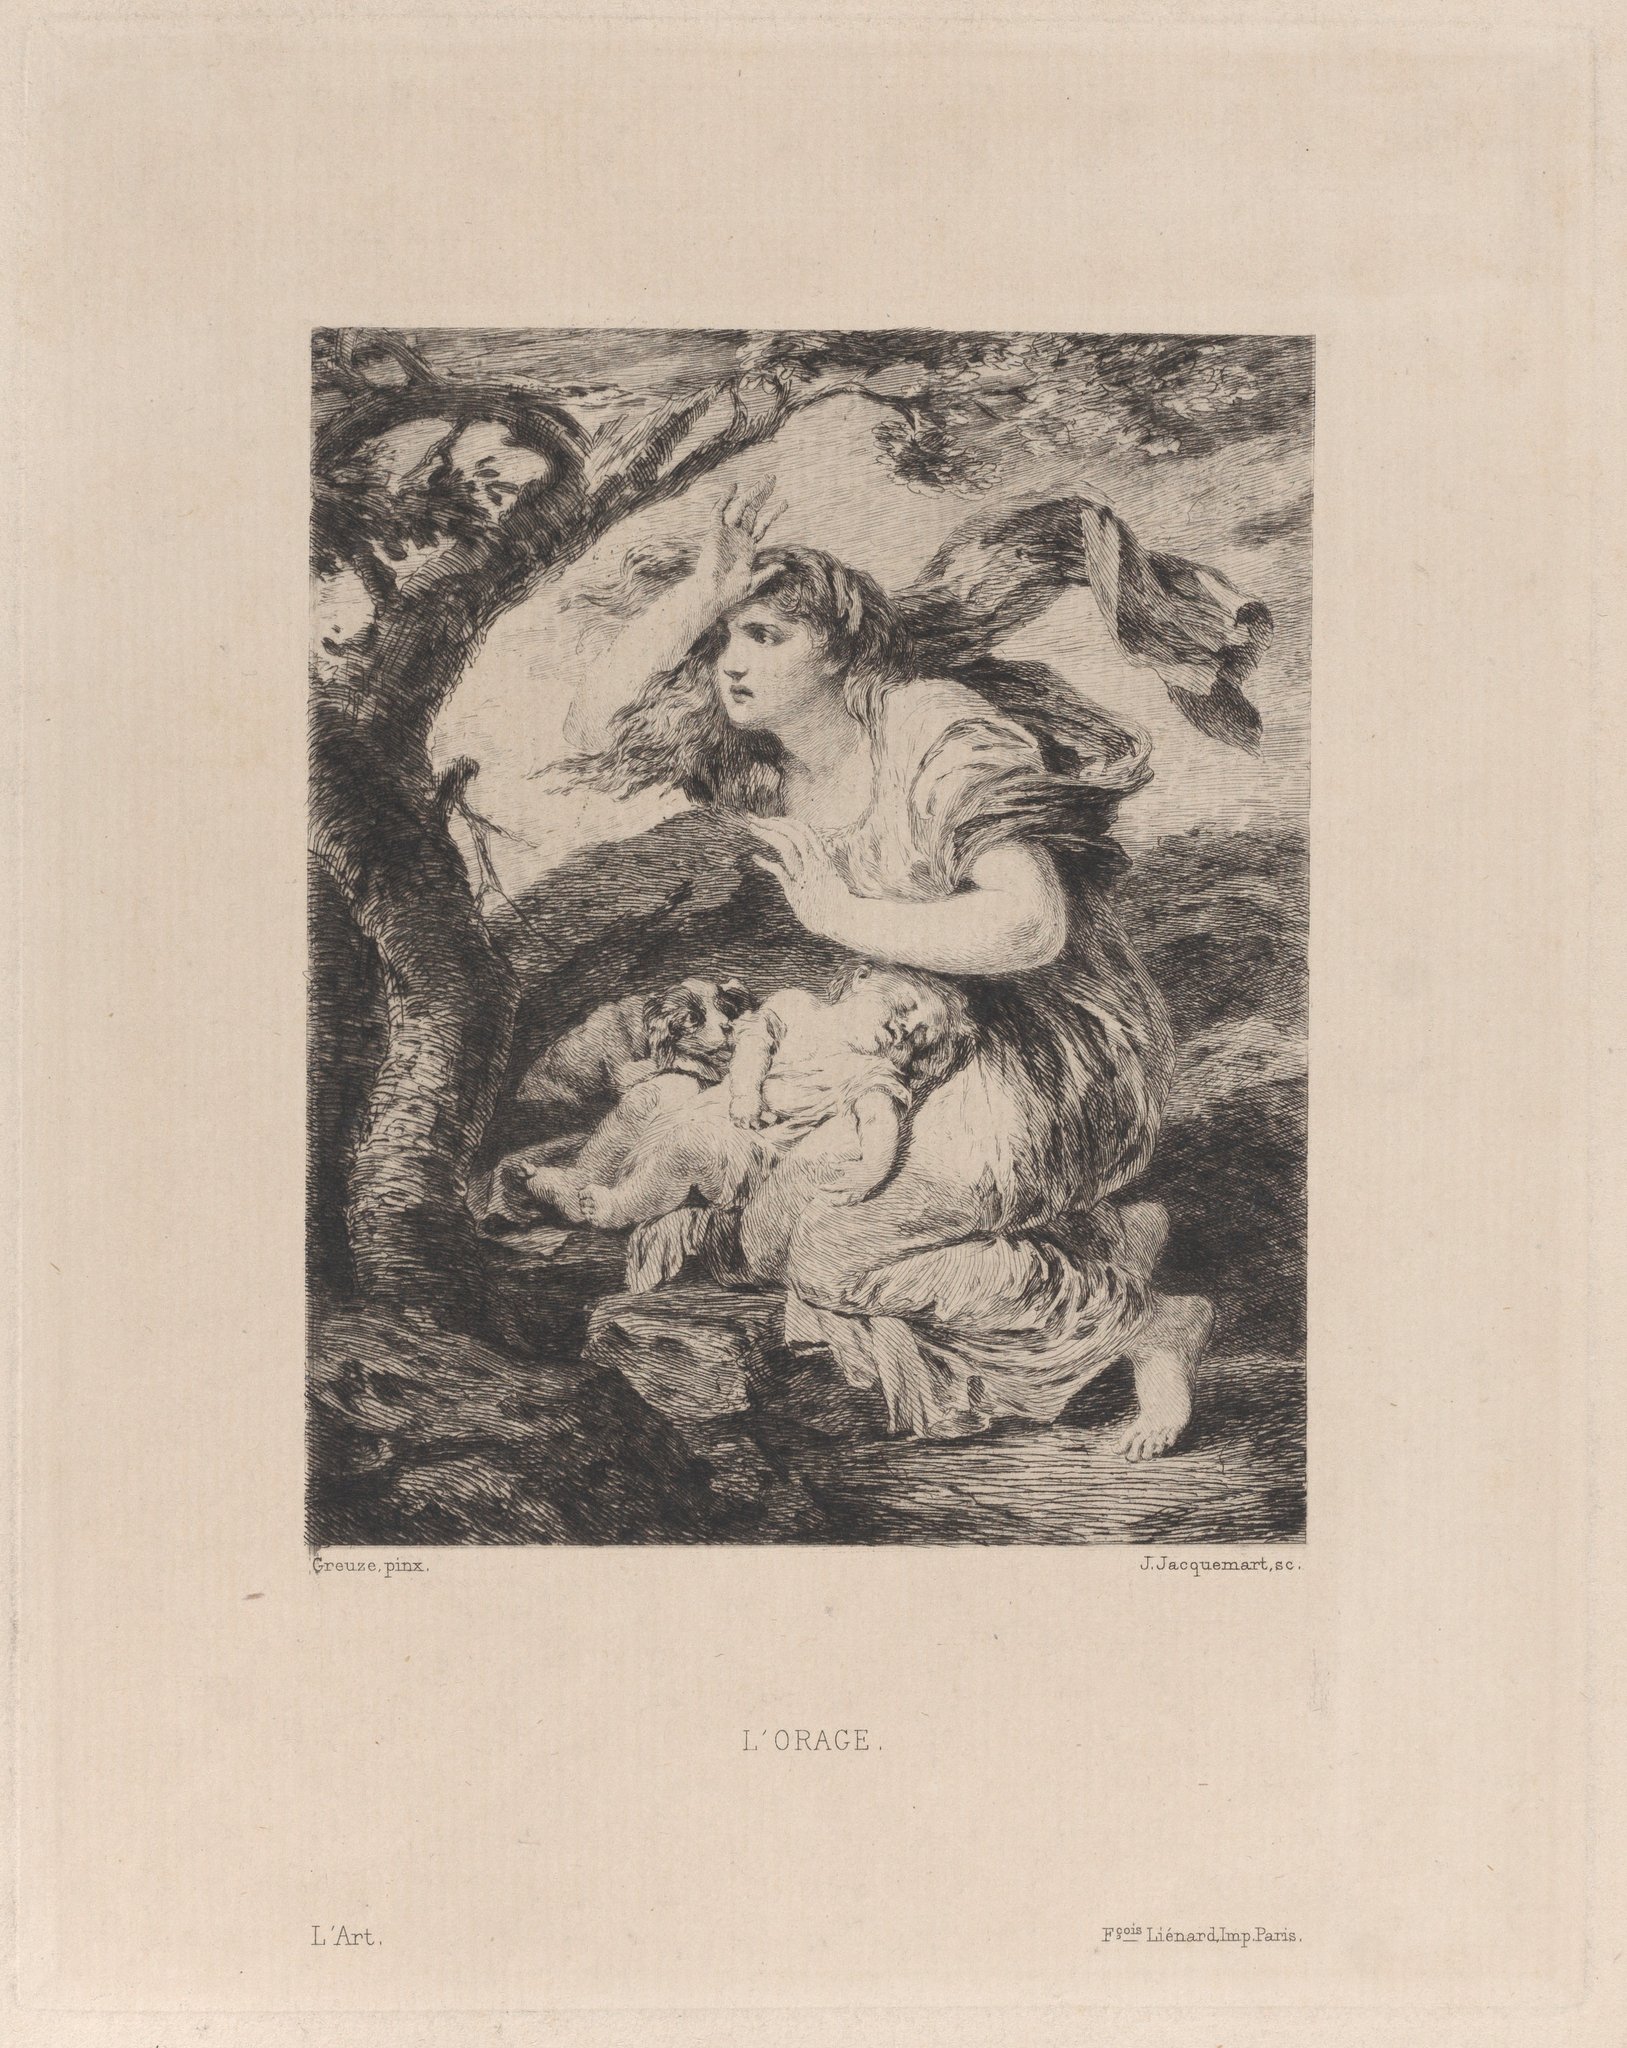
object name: print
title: The Storm, after Greuze, from "L'Art"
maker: jules-ferdinand jacquemart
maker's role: artist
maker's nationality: french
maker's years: 1837-1880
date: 1873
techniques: etching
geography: paris